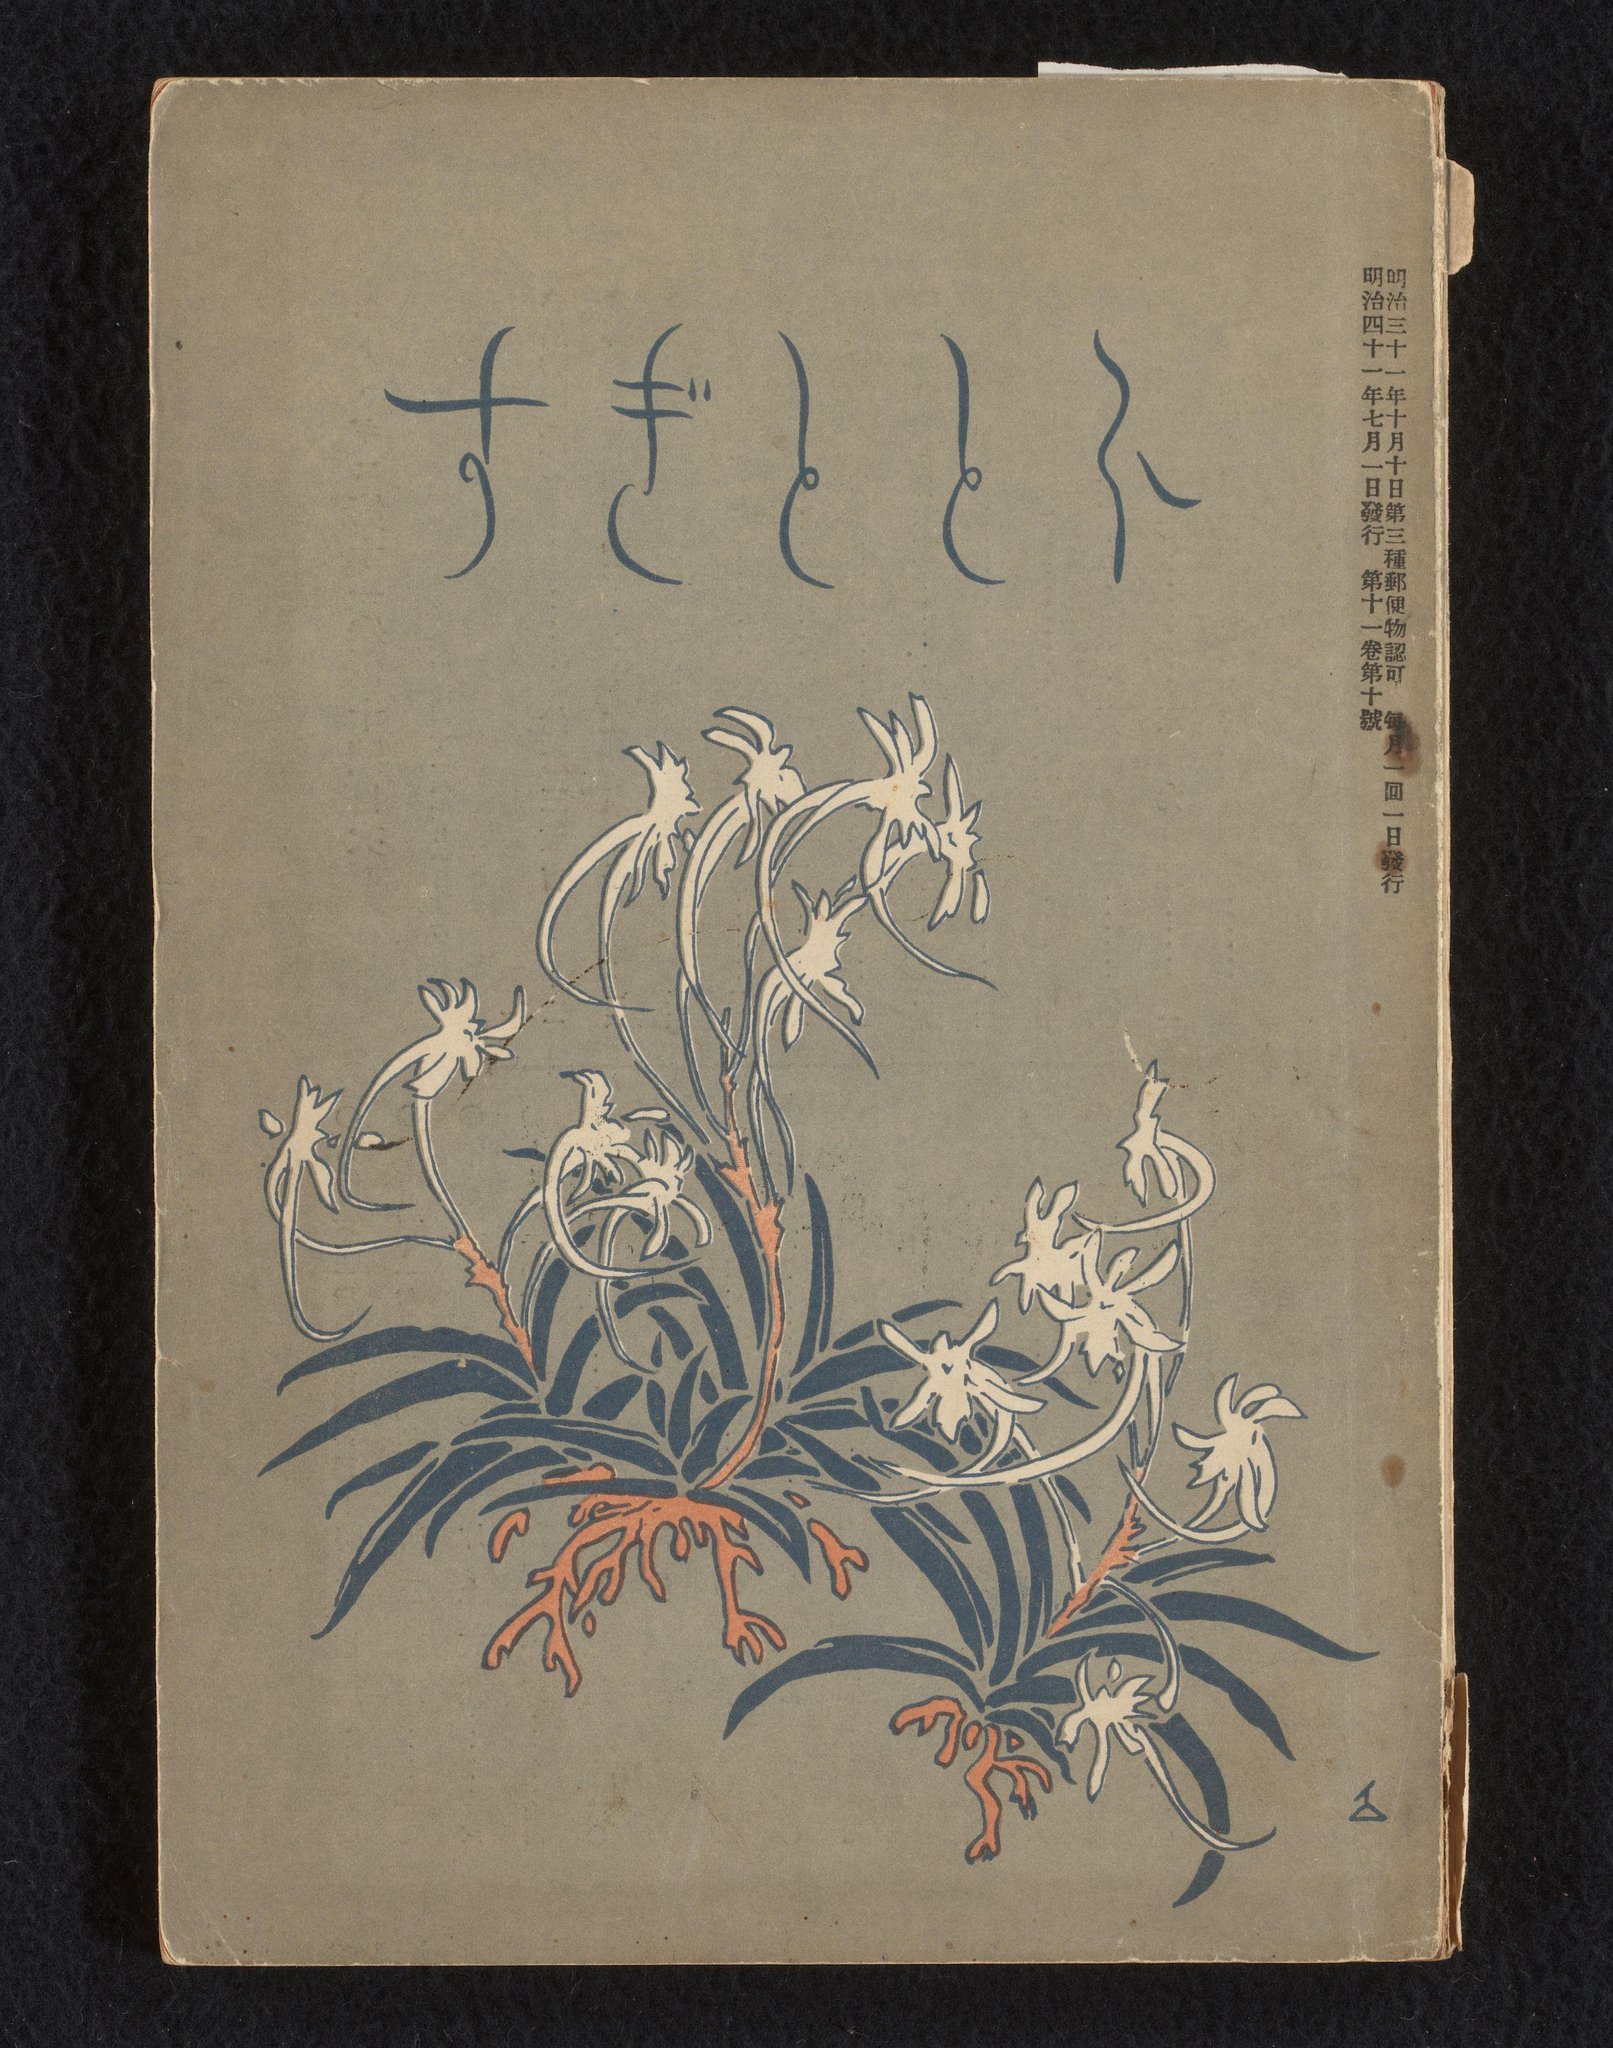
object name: magazine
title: Juli 1908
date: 1908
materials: paper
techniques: woodcut, letterpress printing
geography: japan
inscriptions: date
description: Ontwerp titelplaat: Asai Chû. Overige illustraties: Shimomura Izan (1), Ishii Hakutei (3), Mori Kosen (2), Kikuchi Sokû (1), Yamazaki Gakudô (1), Nagoshi Kunitarô (1), Yoshida Mari (1) en Yamada Kiyoshi (1). Achterkant illustratie: Shôno Munenosuke. Gedichten door Suzuki Miekichi.